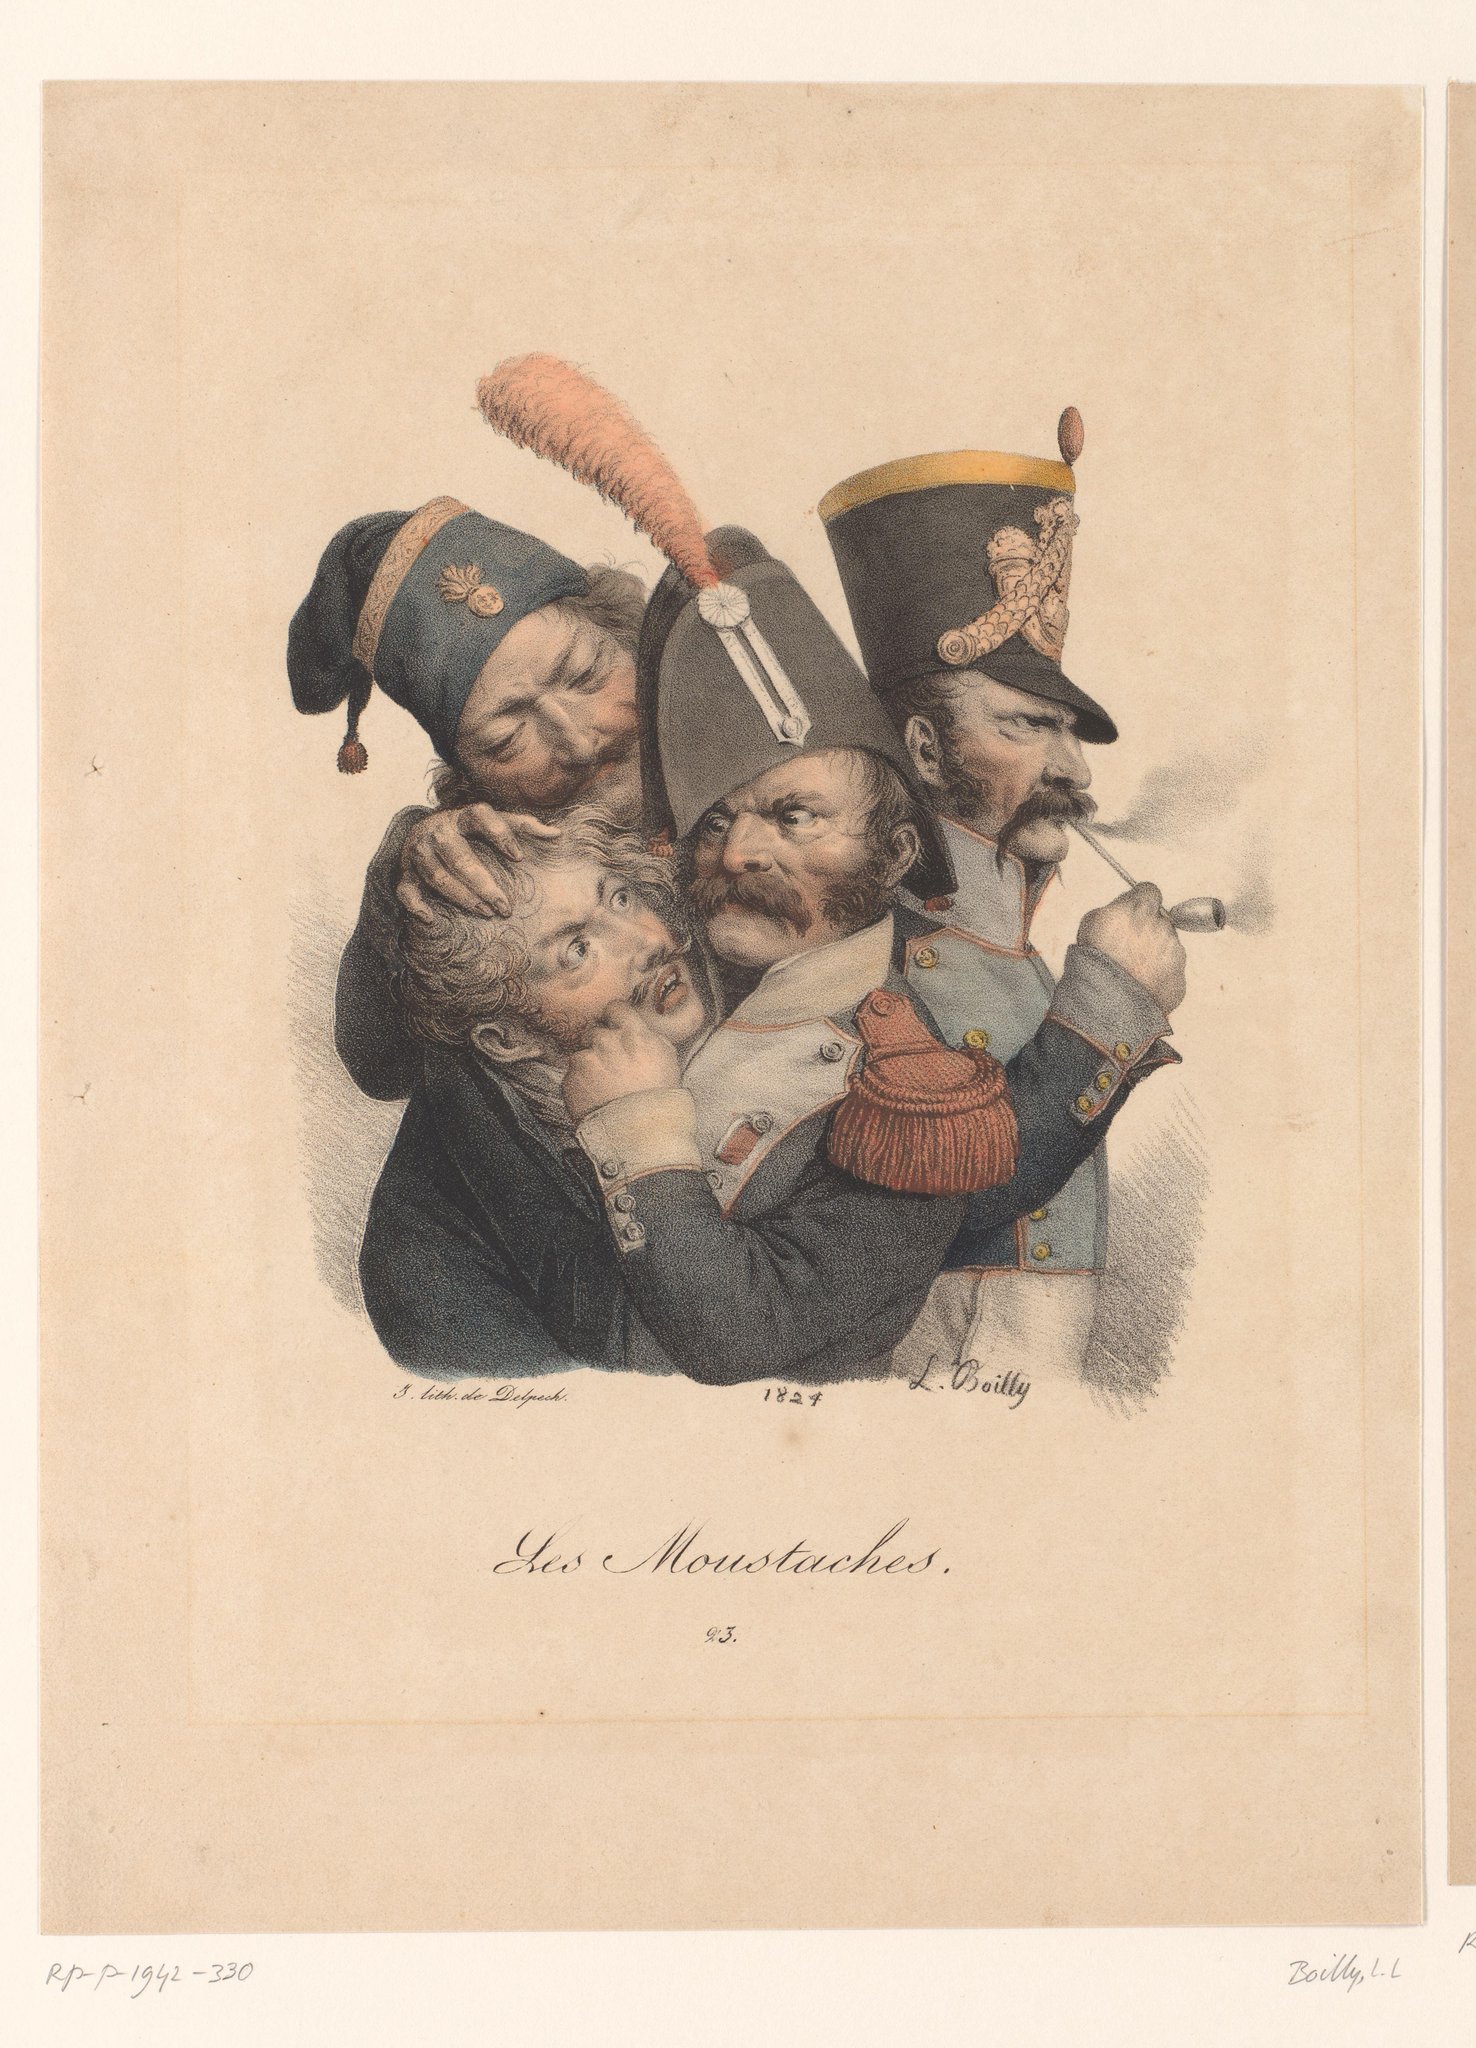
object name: cartoon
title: Gezichten met een grimas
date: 1824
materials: paper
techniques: hand coloring, lithograph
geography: paris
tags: caricatures (human types), moustache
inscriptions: collector's mark: Lugt 2228a, collector's mark: Lugt 2760